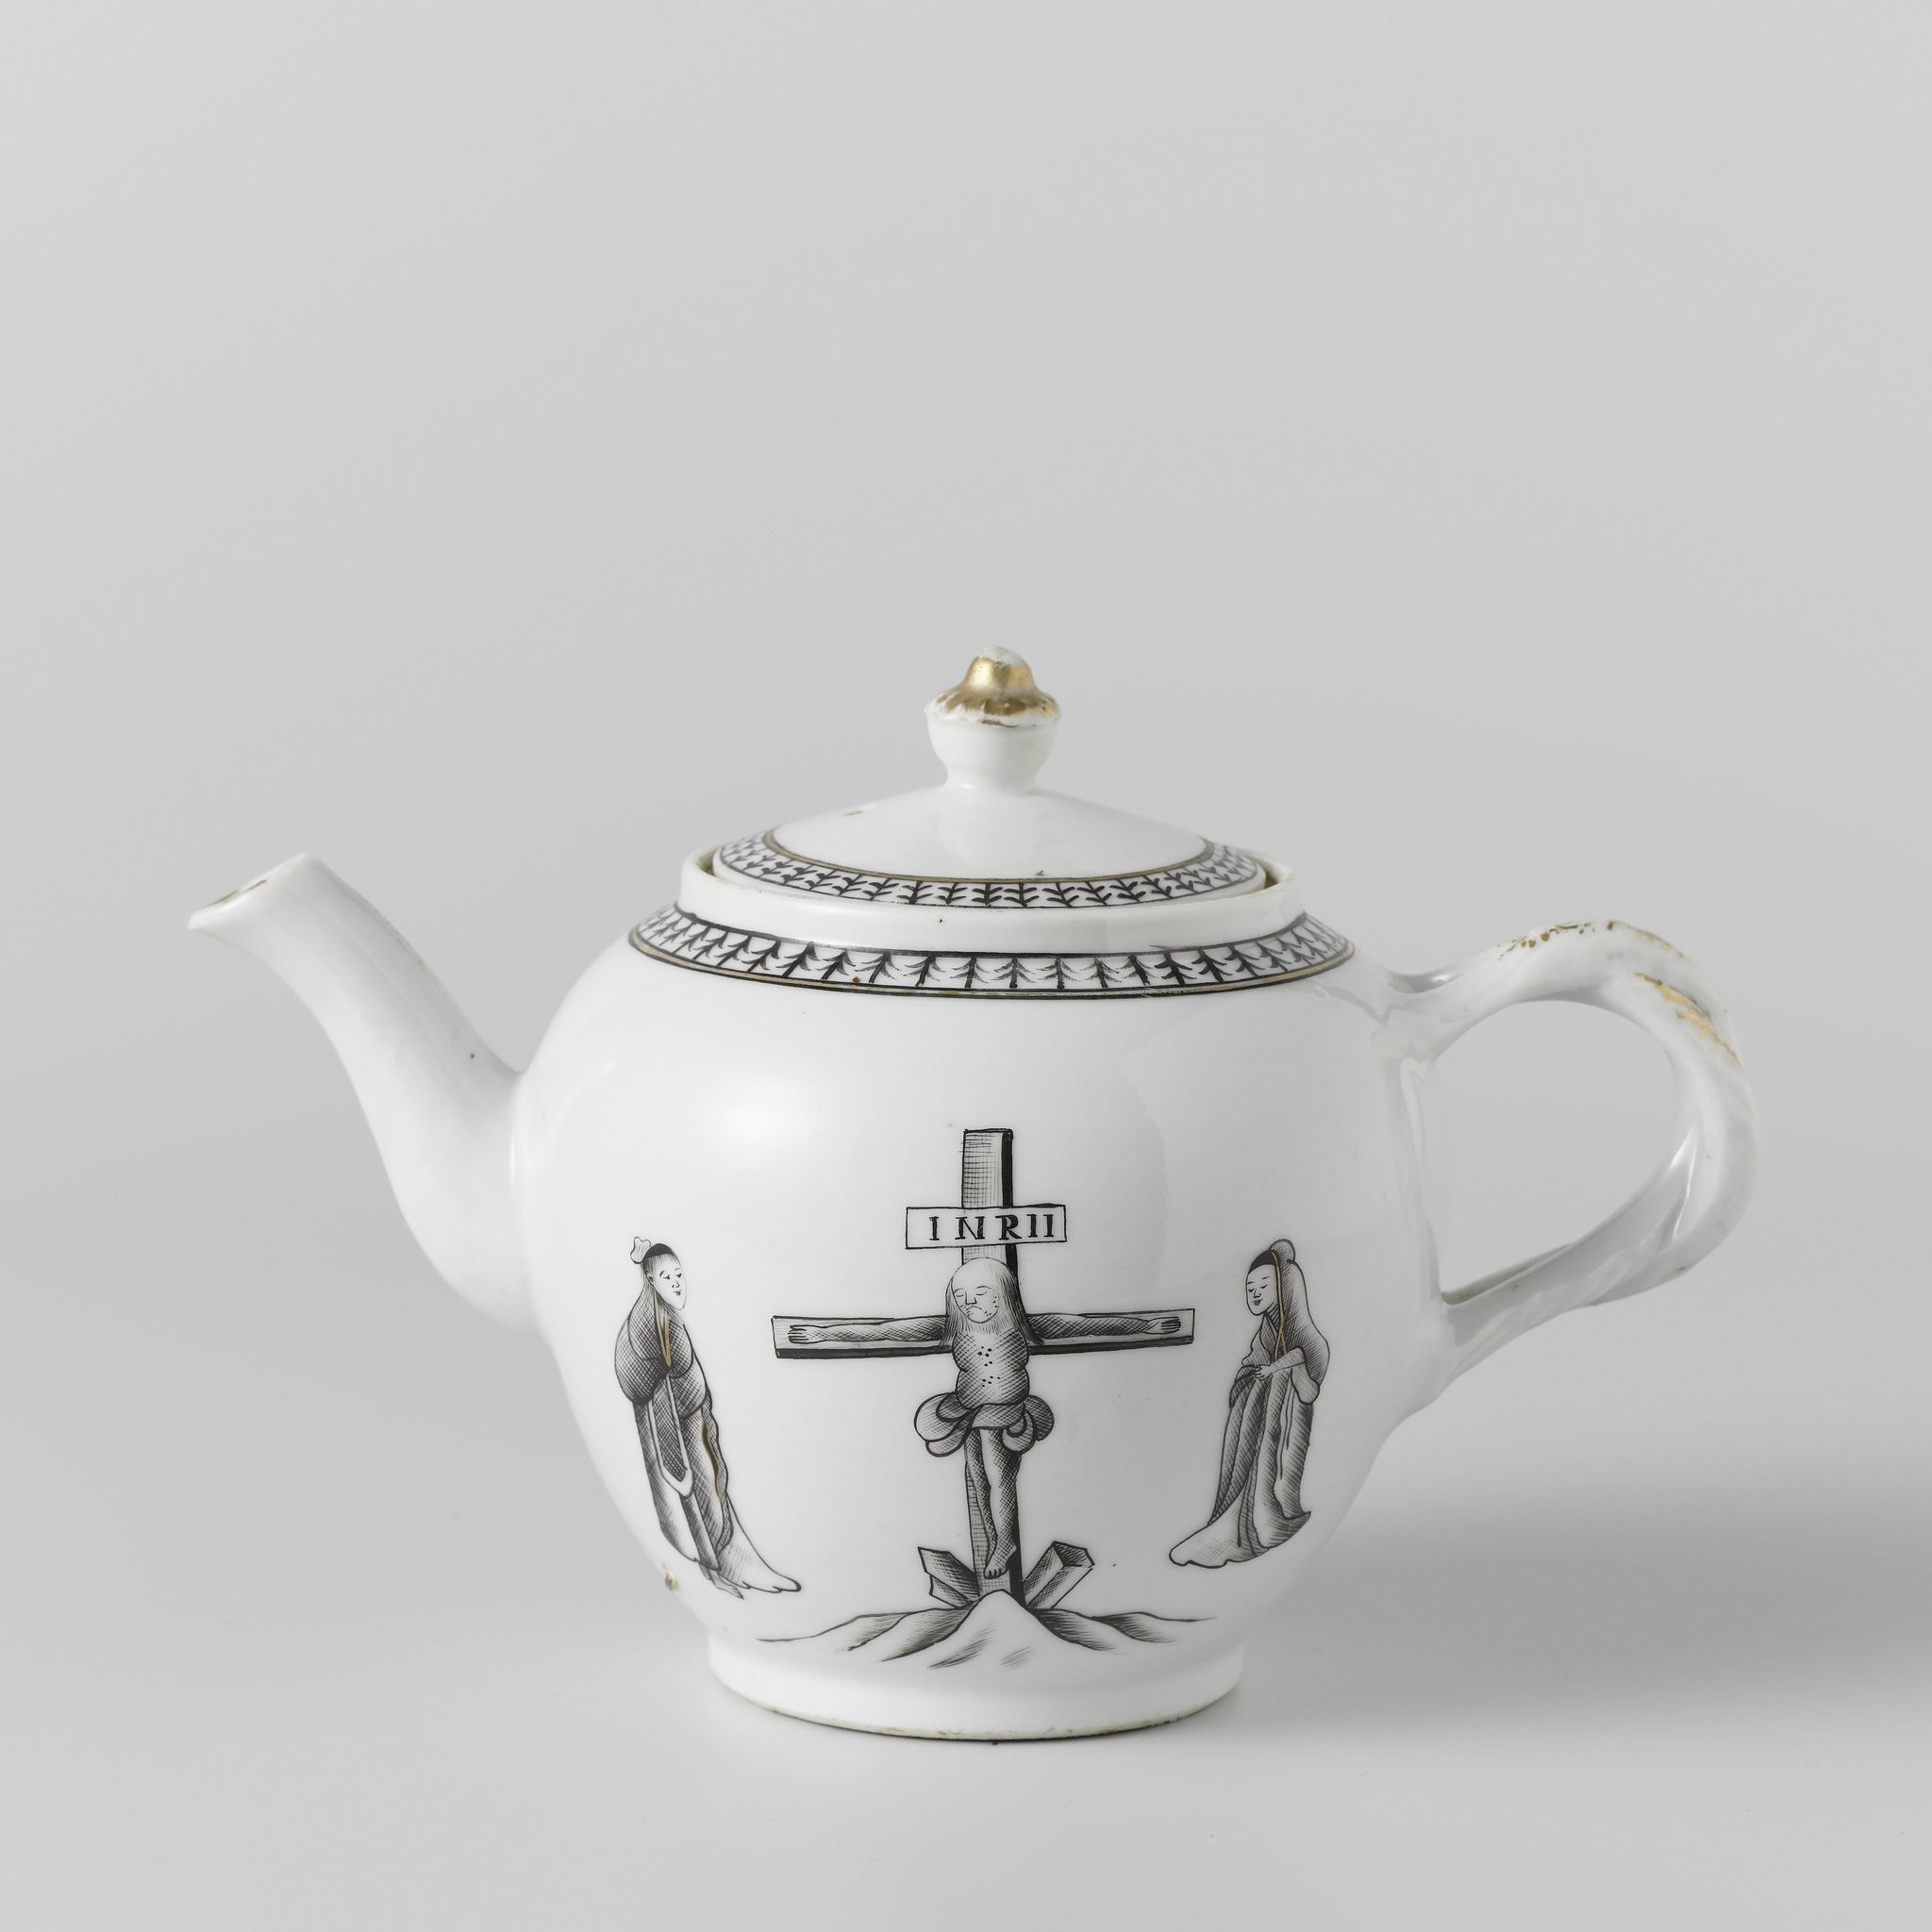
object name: teapot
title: Ovoid teapot with a crucifixion scene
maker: Anonymous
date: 1780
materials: glaze, gold, paint, porcelain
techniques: firing, gilding, turning, vitrification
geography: china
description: Eivormige theepot van porselein met ingegrift, gevlochten c-vormig oor, gebogen tuit en deksel, beschilderd op het glazuur in zwart en goud. Op de buitenzijde een voorstelling van de Kruisiging met de twee Maria's; de schouder en de dekselrand met een band met een decoratief patroon. Onderdeel van een theeservies. Europese voorstelling in encre de Chine.